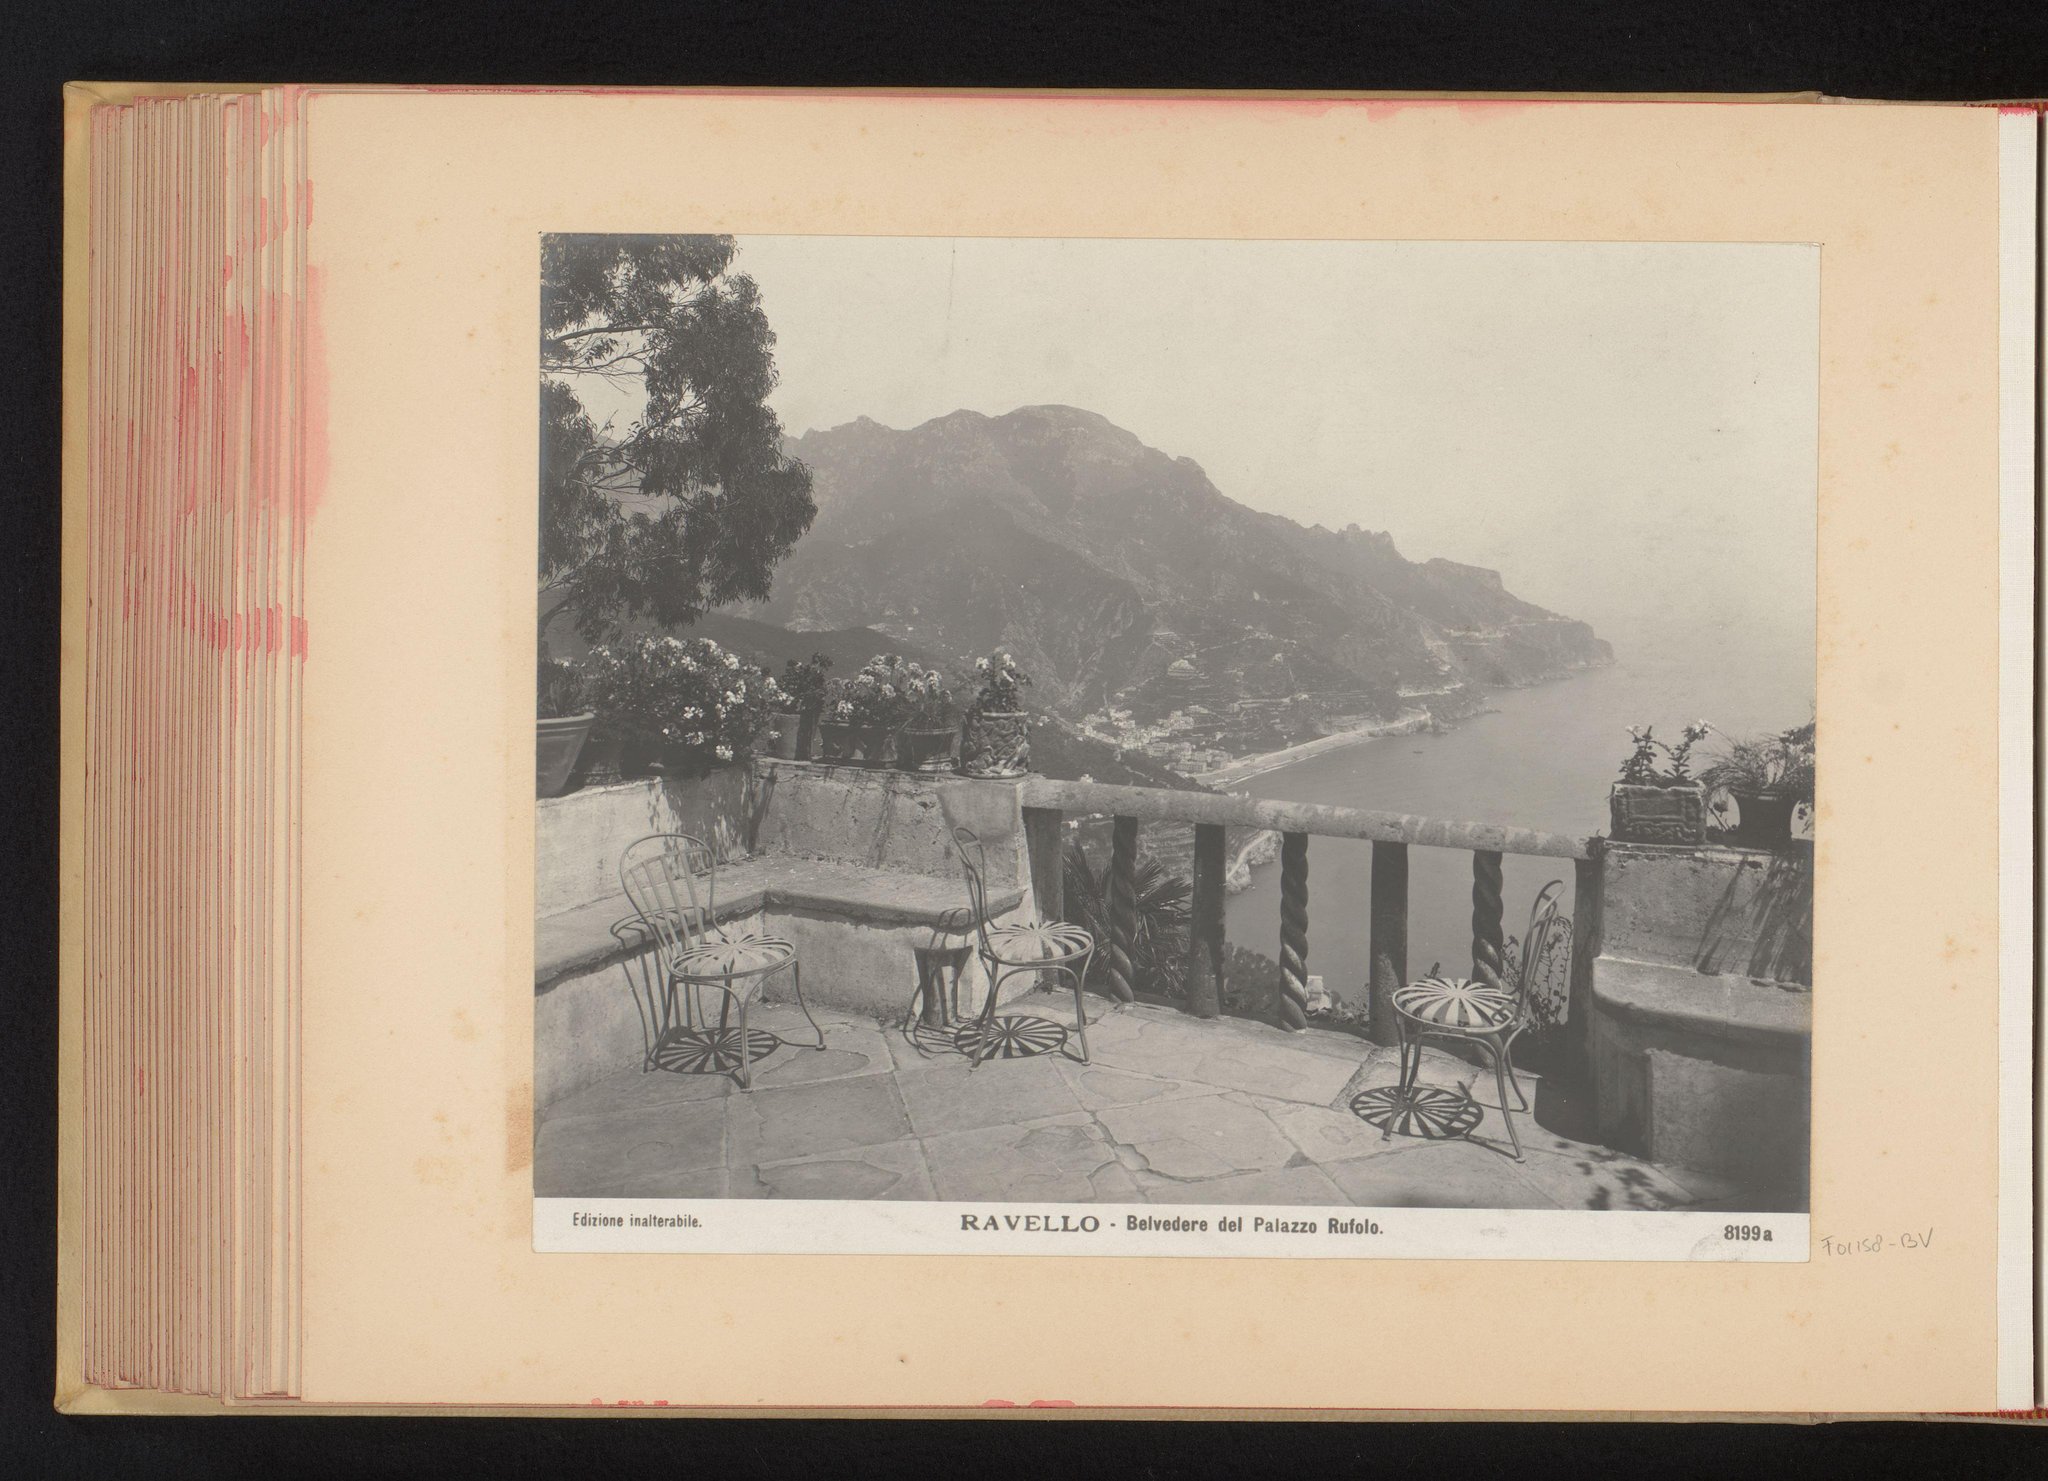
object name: photograph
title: Ravello - Belvedere del Palazzo Rufolo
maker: Anonymous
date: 1875-1907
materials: photographic support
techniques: gelatin silver print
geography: ravello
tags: city-view in general; 'veduta', rocky coast, balcony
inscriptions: number: ‘8199a’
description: Onderdeel van Fotoalbum met opnames van bezienswaardigheden en kunstwerken in Italië.